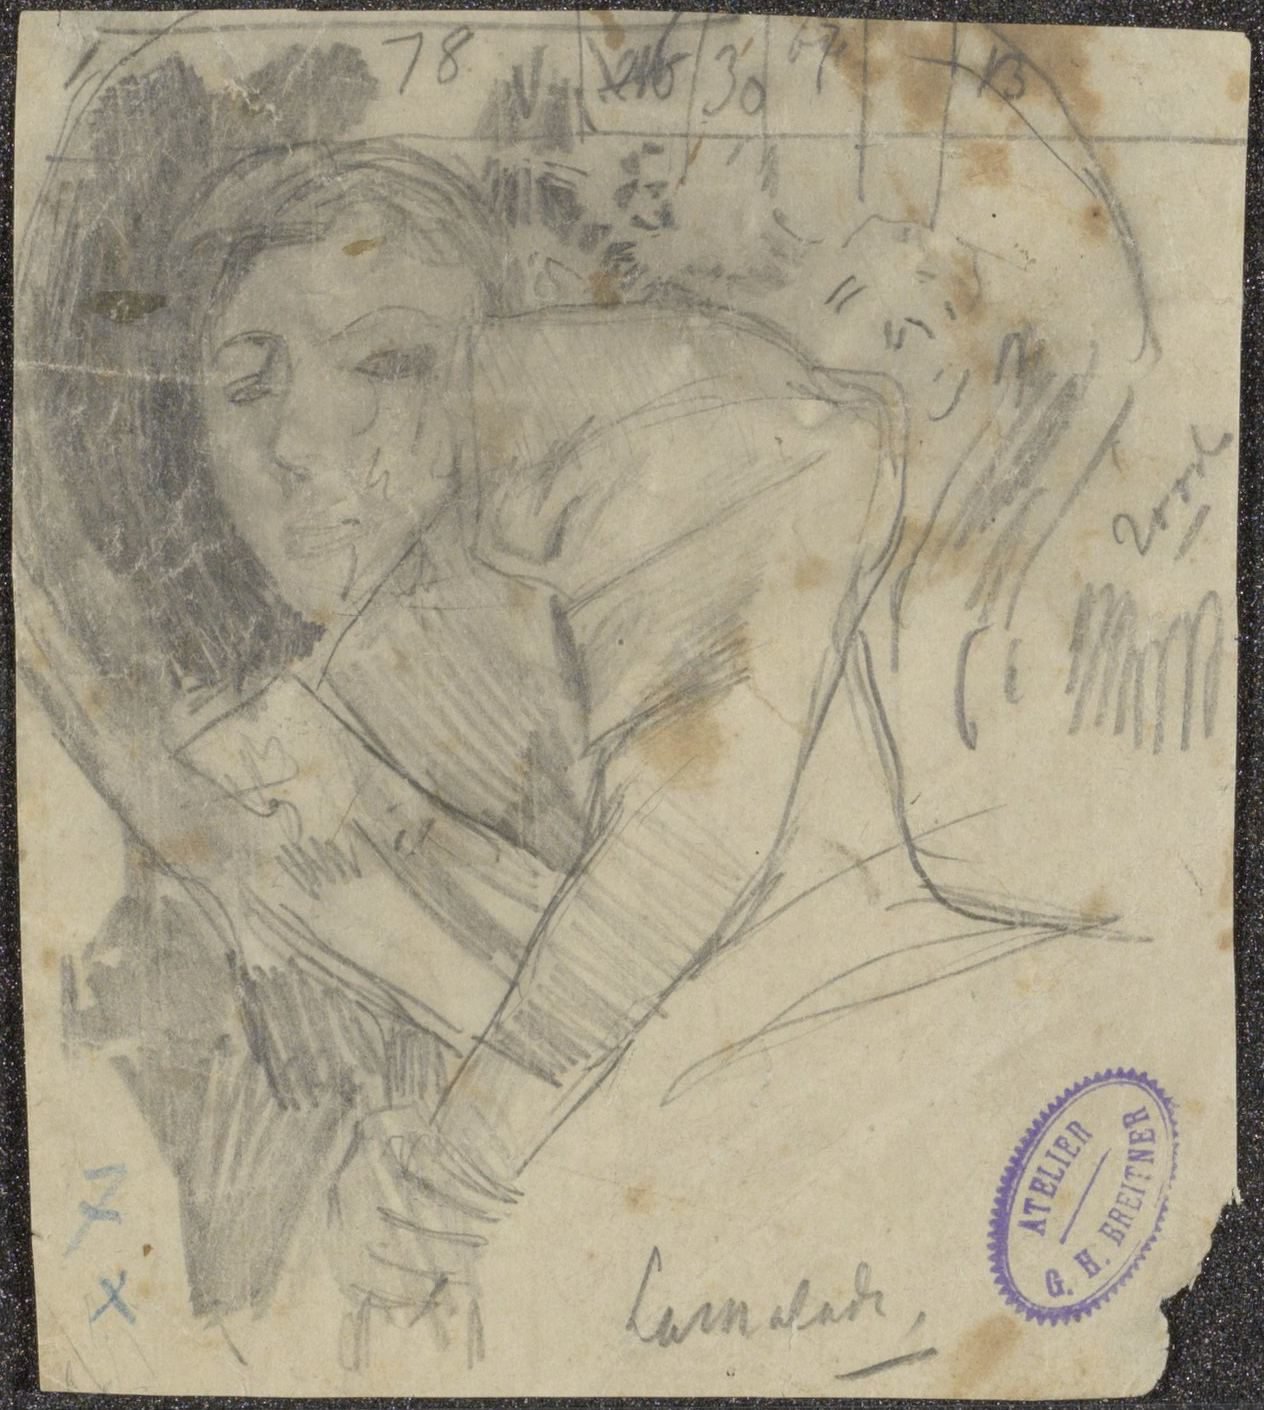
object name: drawing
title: Zieke vrouw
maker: george hendrik breitner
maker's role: draughtsman, painter, print maker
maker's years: 1857-1923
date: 1897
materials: paper, pencil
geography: amsterdam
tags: adult woman, patient, sick person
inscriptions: :, annotation: ‘La malade’, collector's mark: Lugt 2228, workshop stamp: Lugt 291d